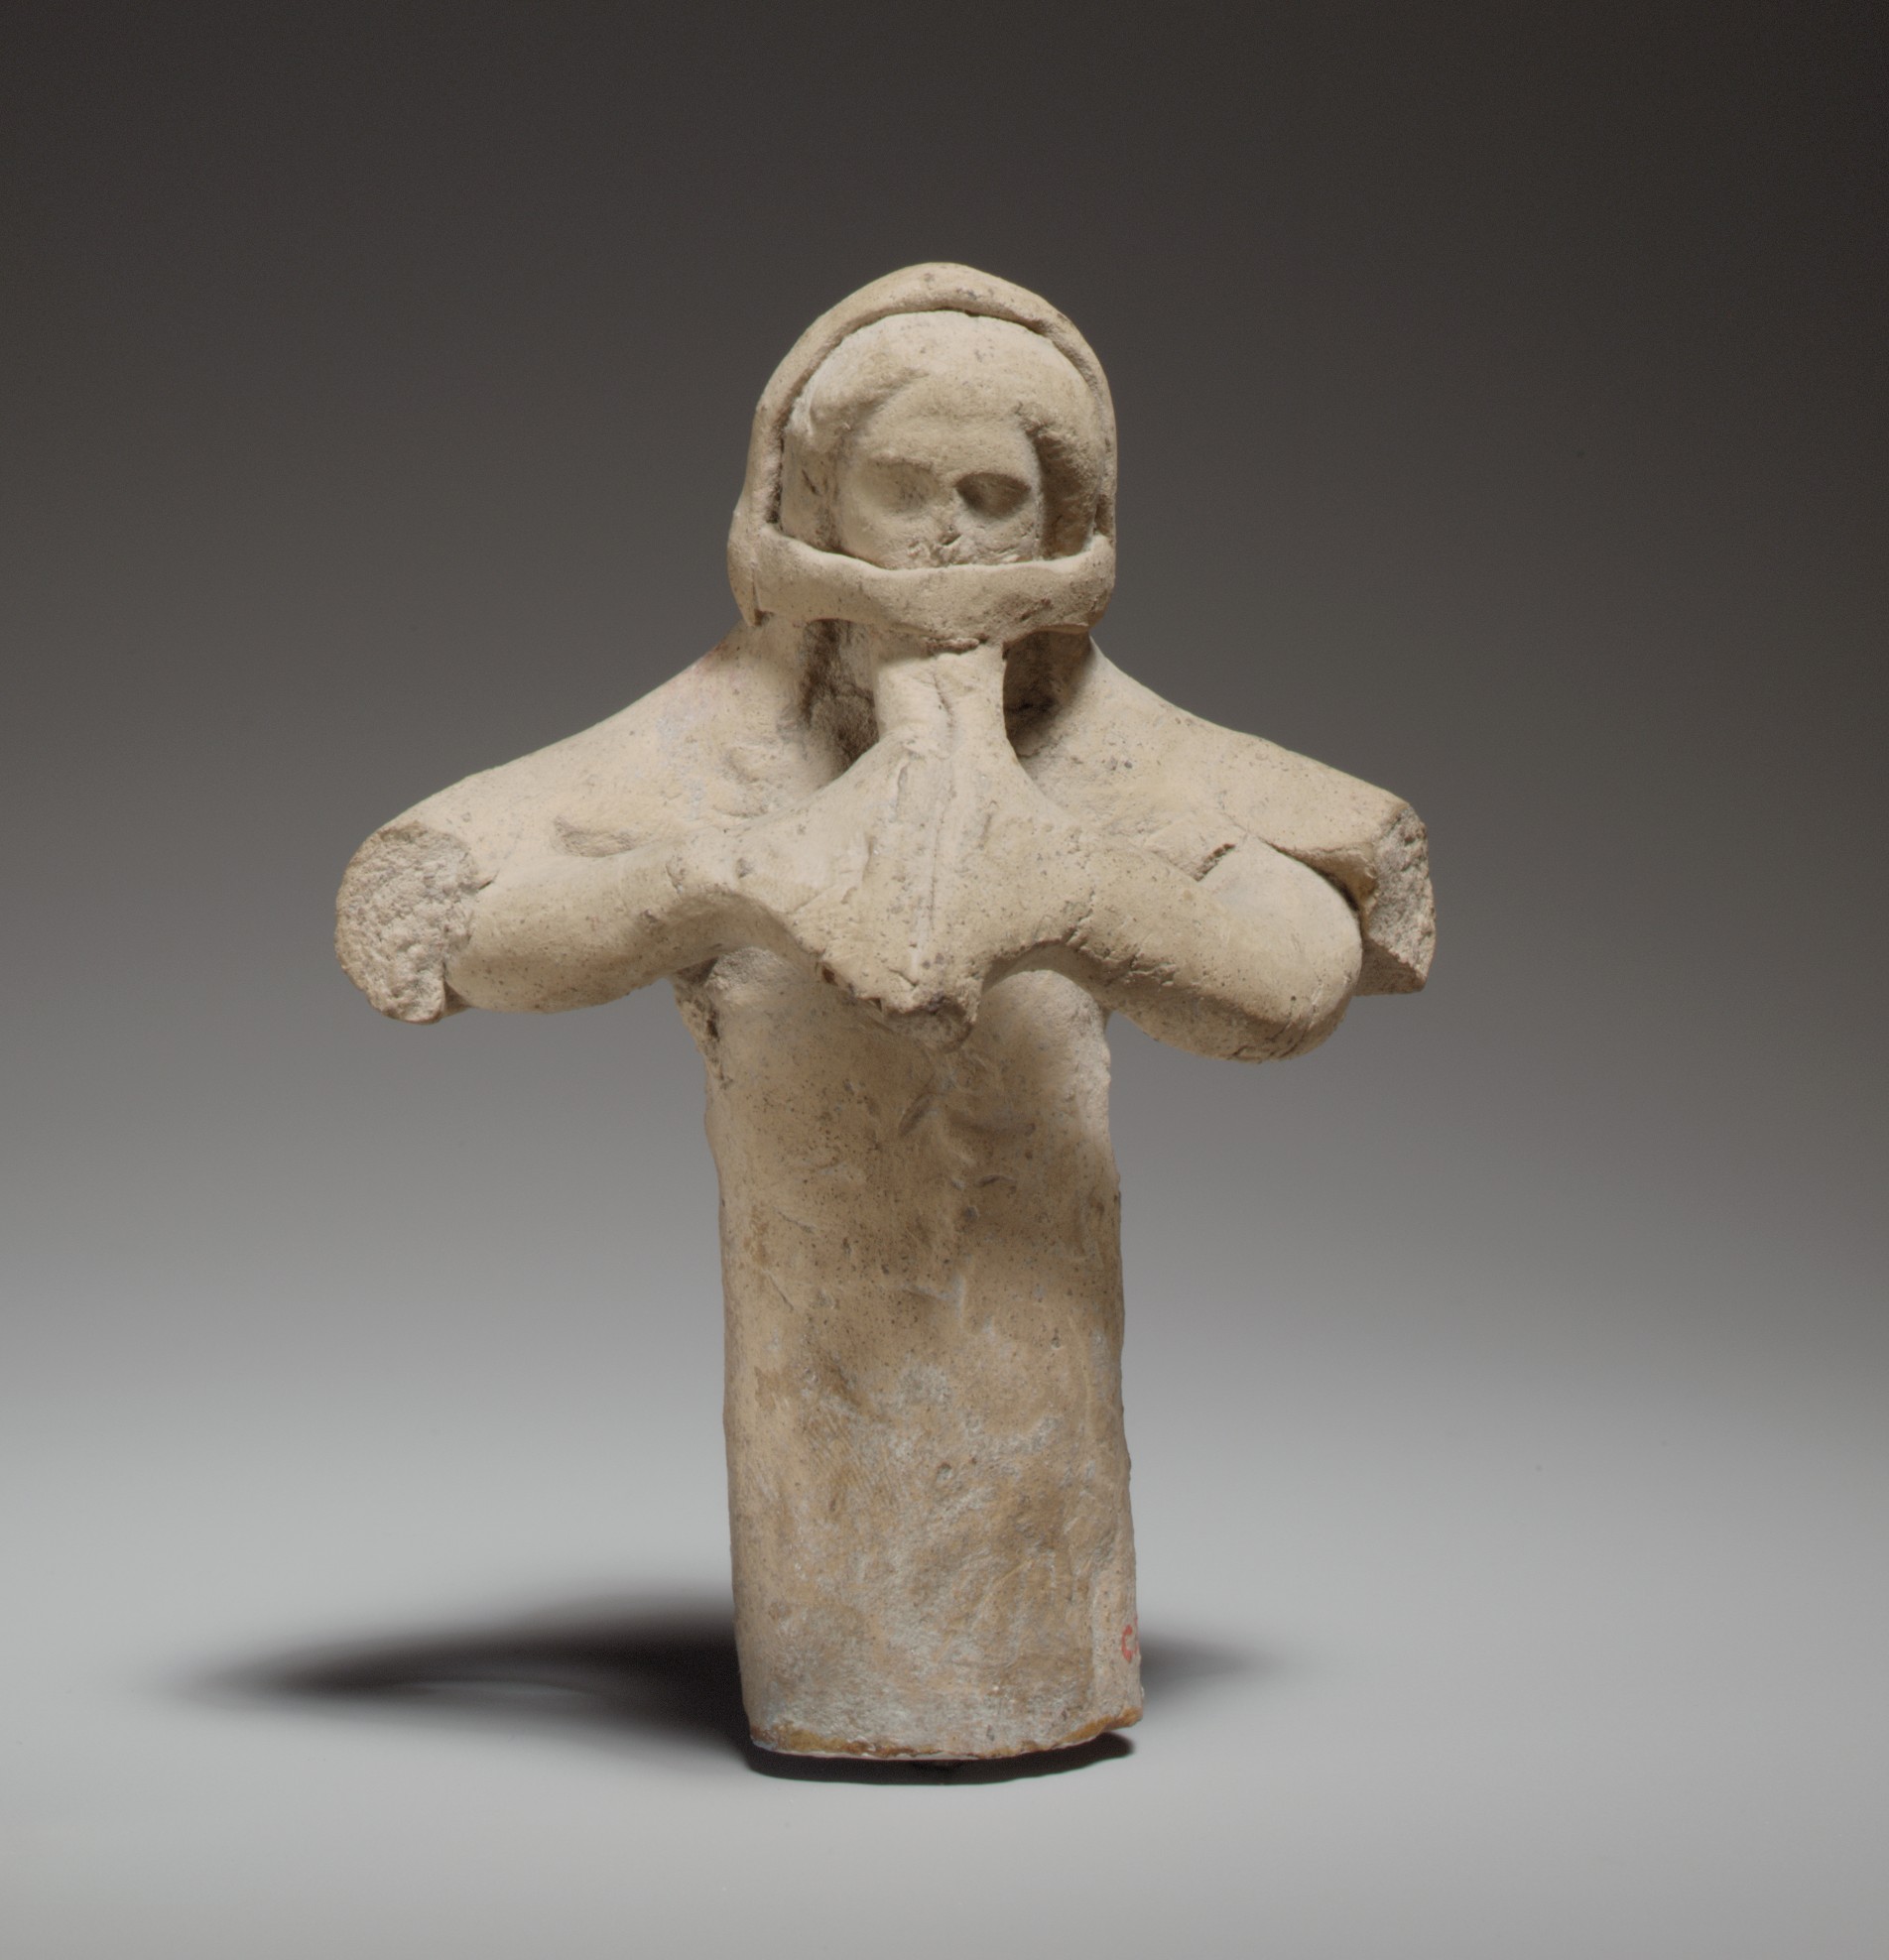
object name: statuette of a flute player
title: Standing female flute player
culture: cypriot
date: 434-368 BCE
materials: terracotta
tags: women,flutes,musicians